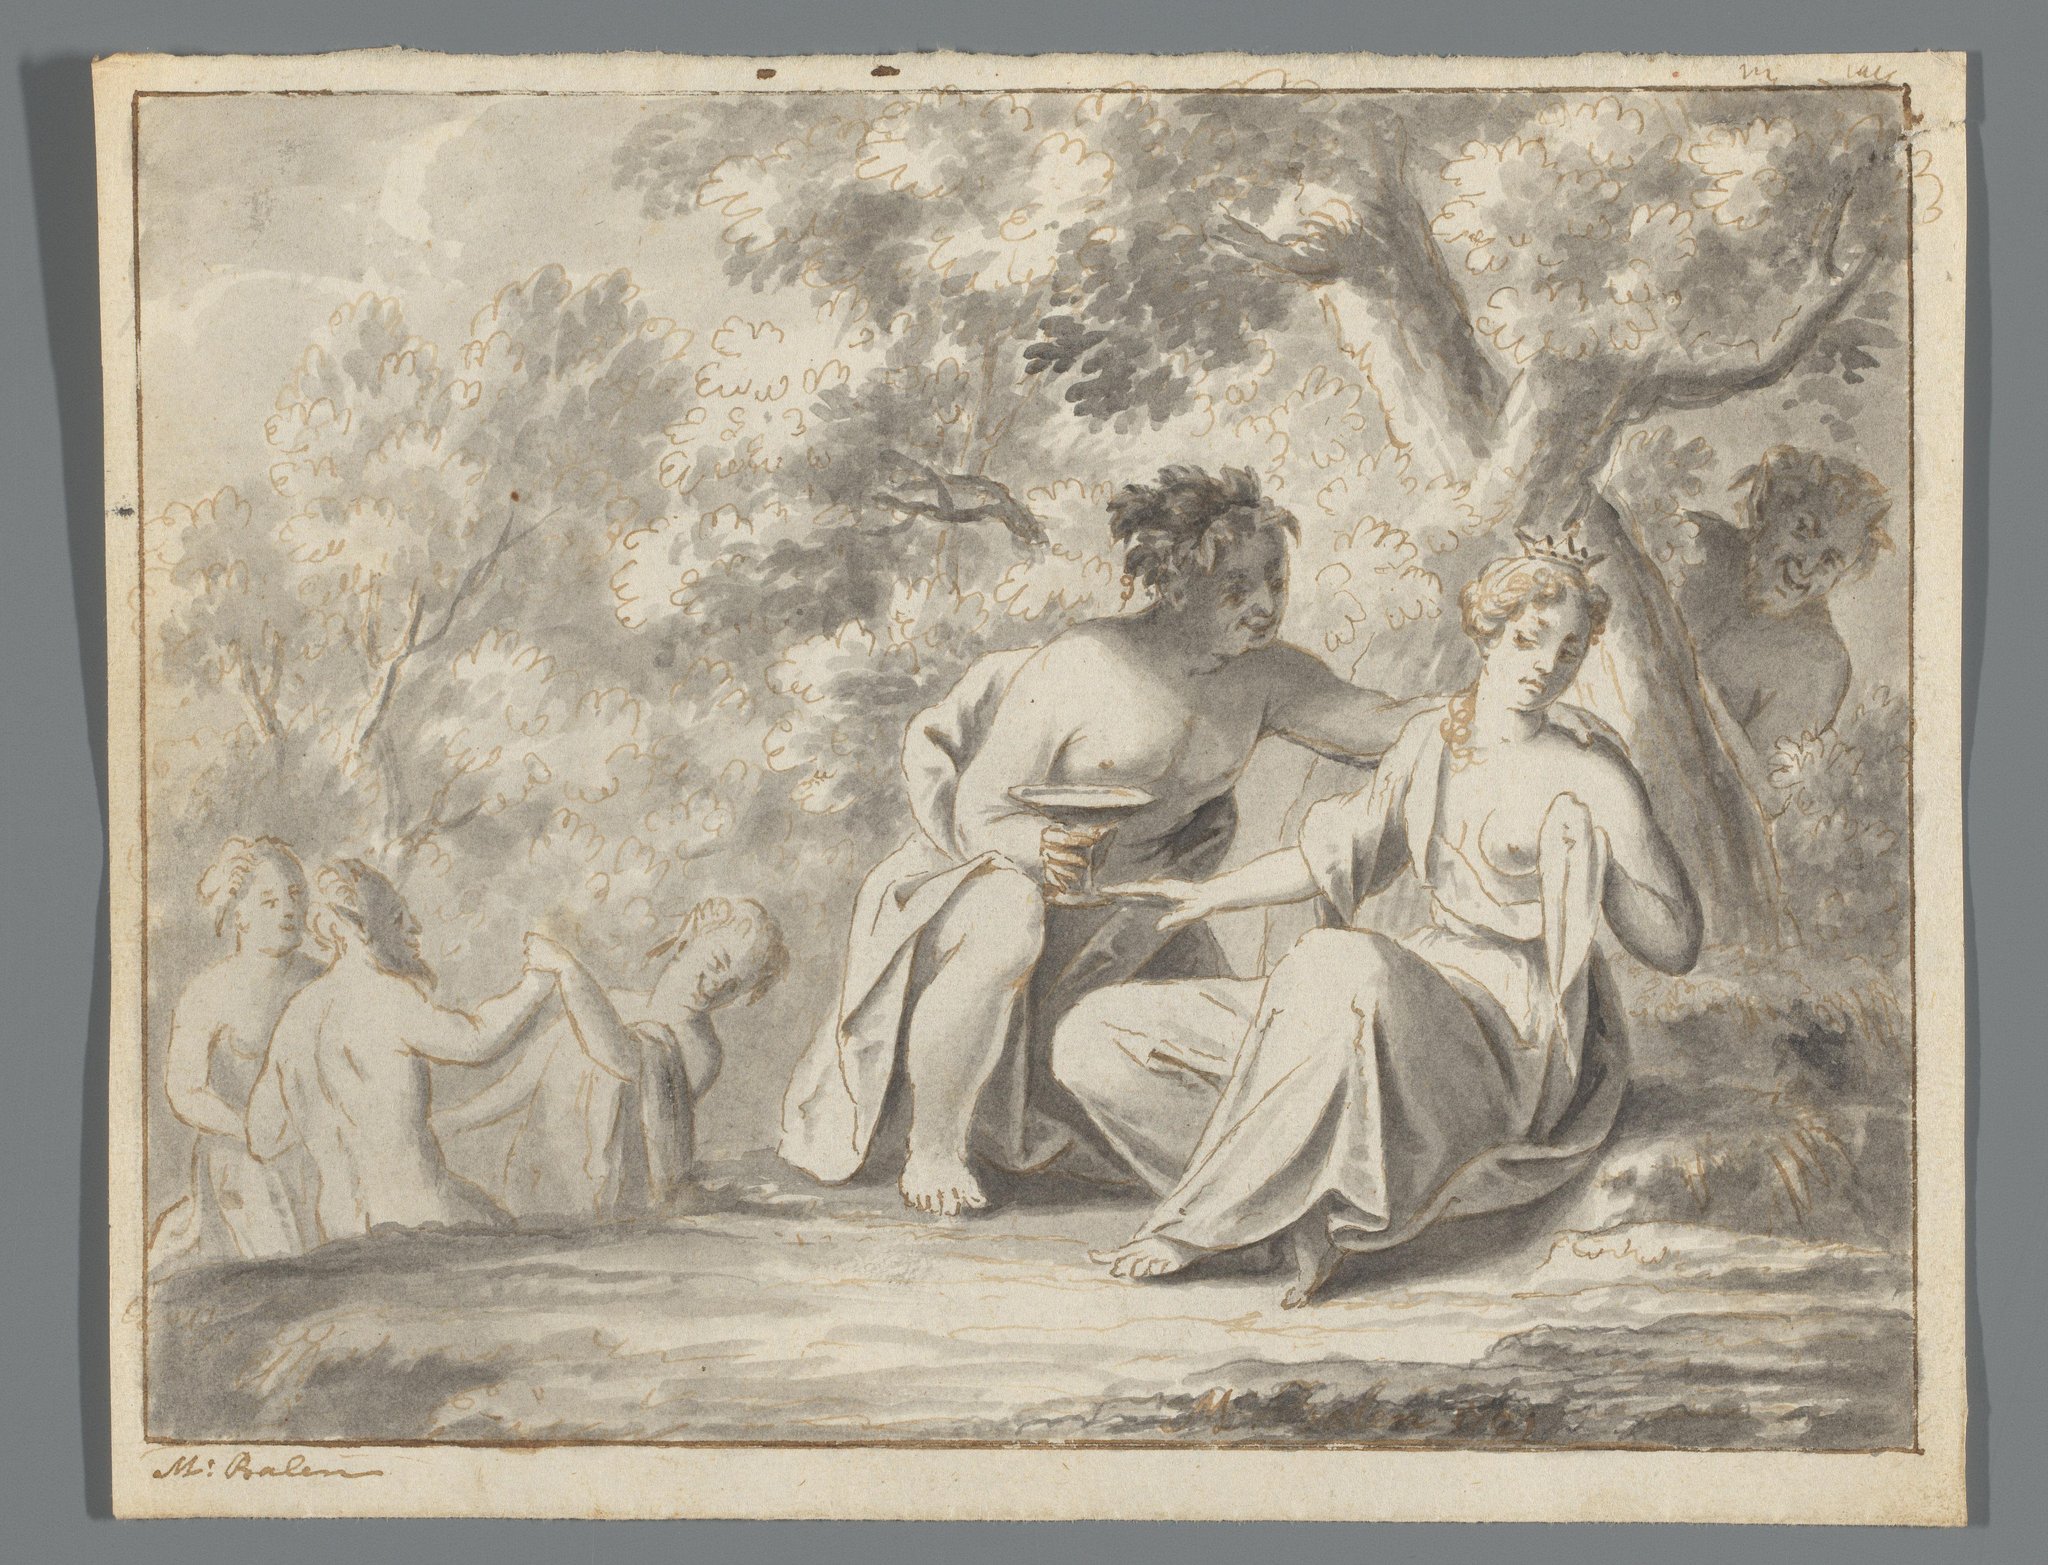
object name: drawing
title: Bacchus en Ariadne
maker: matthijs balen (1684-1766)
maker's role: draughtsman, painter, print maker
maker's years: 1684-1766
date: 1694-1766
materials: paper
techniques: brush, pen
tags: (story of) ariadne and bacchus